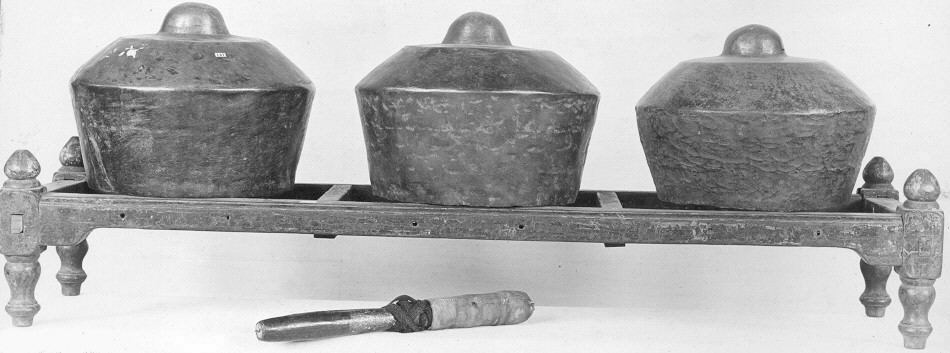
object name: gong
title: Gongs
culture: burmese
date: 1867-1900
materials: bronze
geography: myanmar